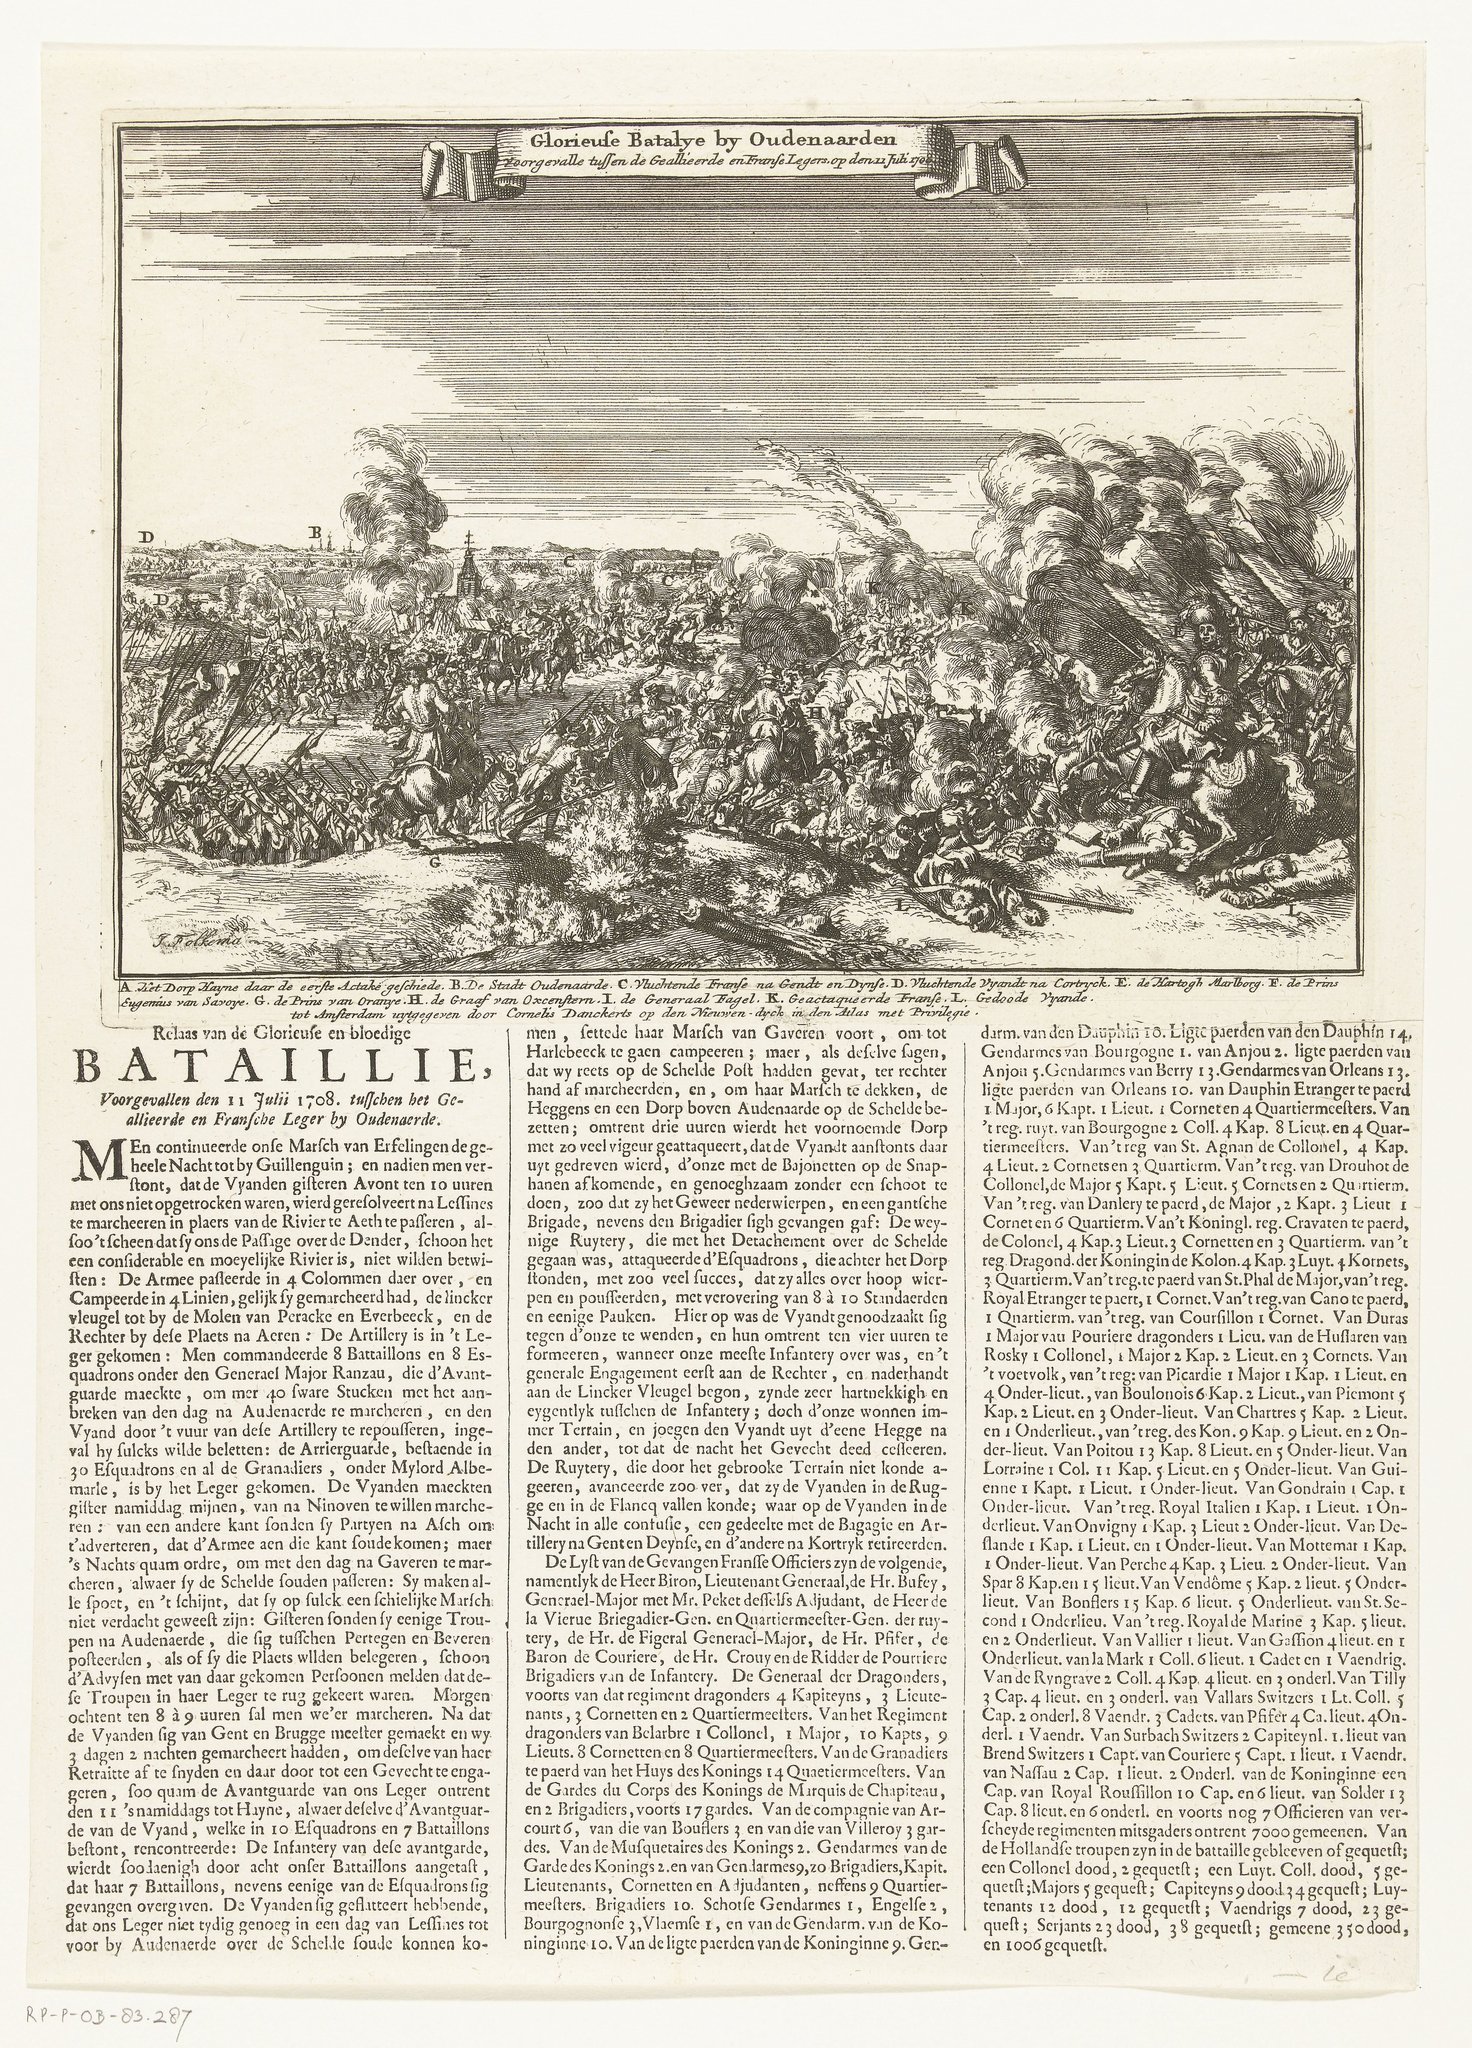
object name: print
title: Glorieuse Batalye by Oudenaarden voorgevalle tussen de Geallieerde en Franse Legers, op den 11 Juli 1708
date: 1708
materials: paper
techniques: etching, letterpress printing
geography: amsterdam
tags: battle (+ land forces)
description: De slag bij Oudenaarde tussen de Geallieerden onder de prins van Savoye en de hertog van Marlborough en de Fransen, 11 juli 1708. In het onderschrift de legenda A-L. Gedrukt op het blad onder de plaat een relaas van de slag in 3 kolommen.